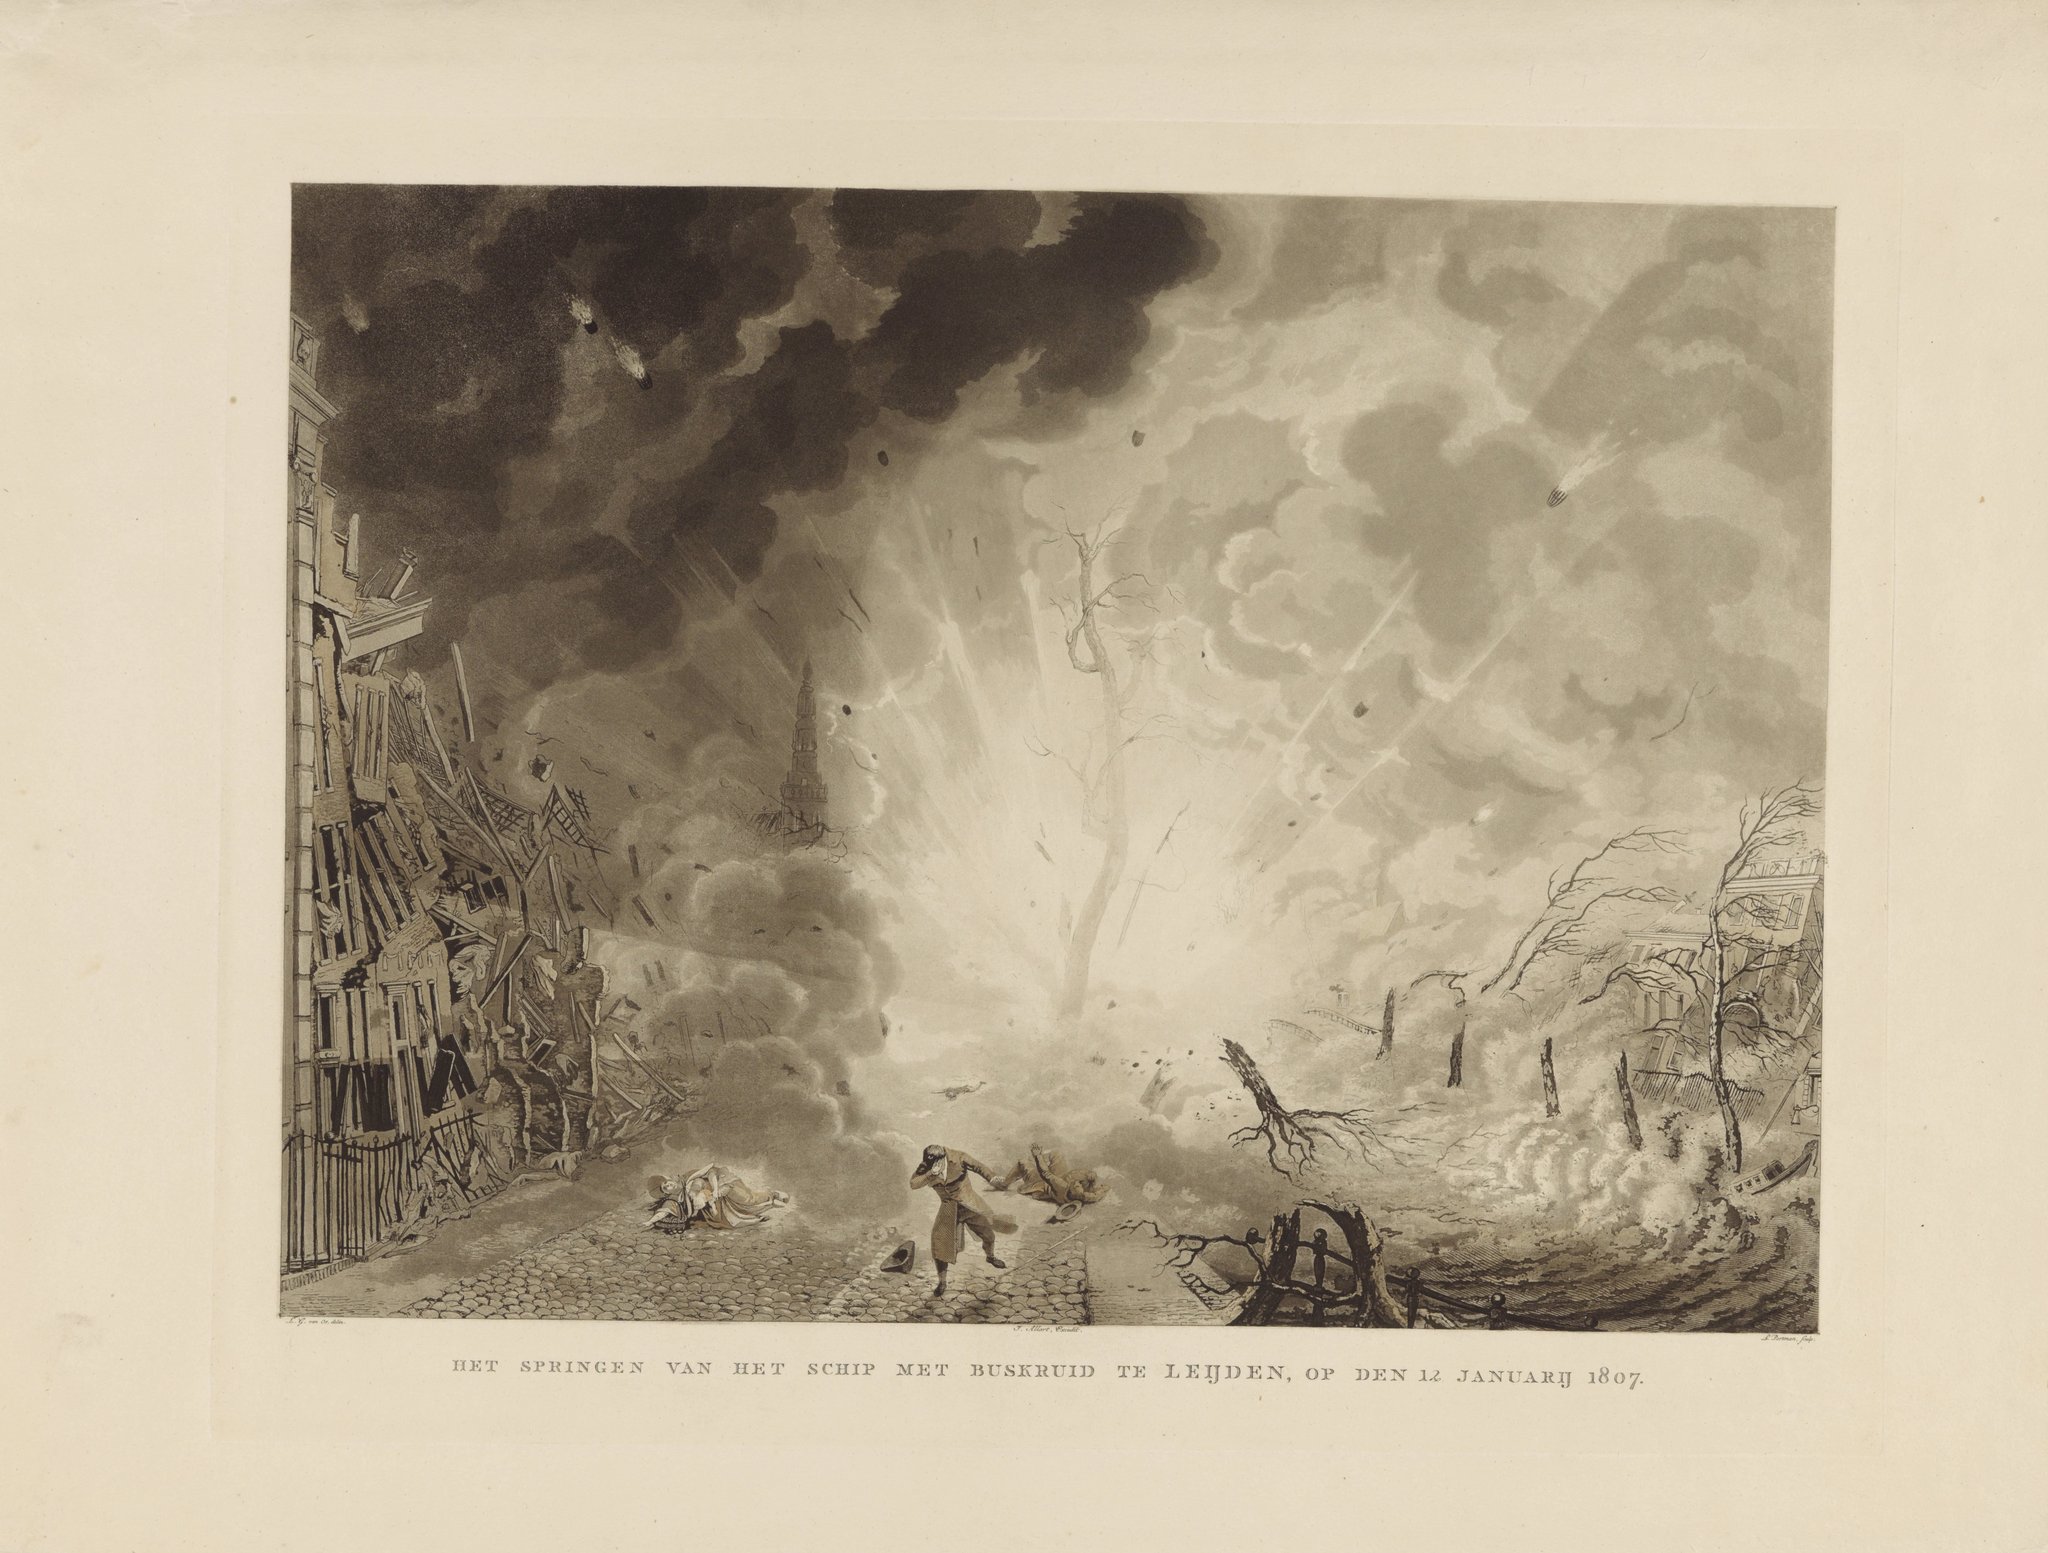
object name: print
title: Ramp van Leiden, 1807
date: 1807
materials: paper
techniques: aquatint, etching, hand coloring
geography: northern netherlands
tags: crafts and industries (+ accidental destruction, failing of production), leiden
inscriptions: collector's mark: Lugt 2233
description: Gezicht op het Steenschuur, een gracht in het verlengde van het Rapenburg, gezien vanaf de Nieuwsteegburg. Links op de achtergrond de Lodewijkskerk te Leiden. In het midden ontploft het schip met buskruit. Een vrouw met haar kind en twee mannen worden op de grond geworpen.